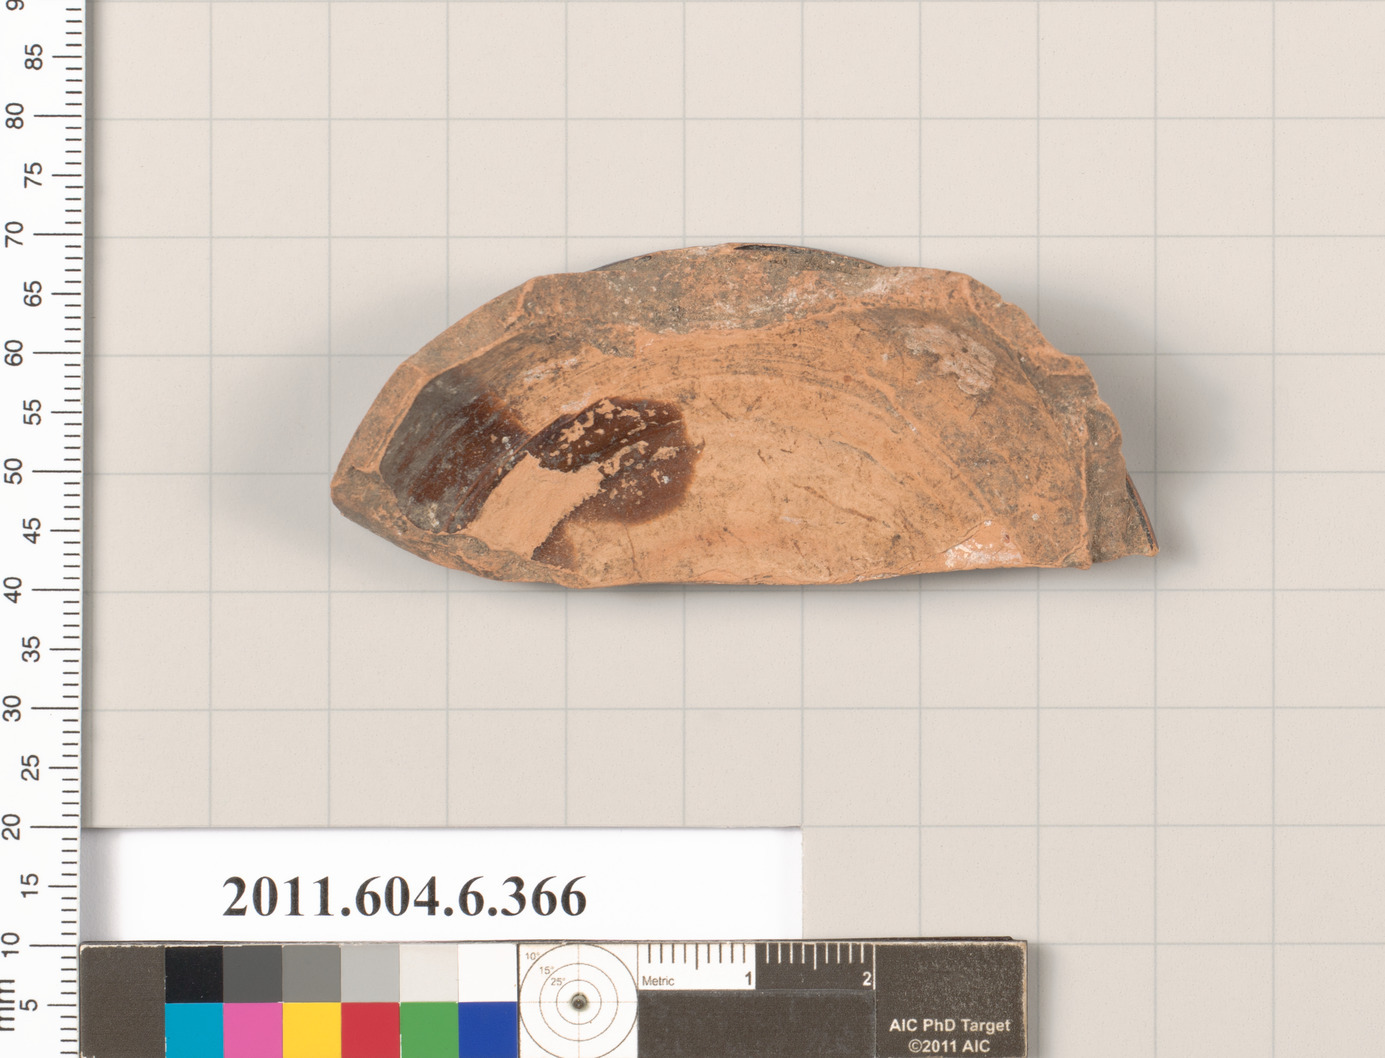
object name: undetermined closed shape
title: Terracotta fragment of a closed shape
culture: greek, attic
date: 600-401 BCE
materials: terracotta